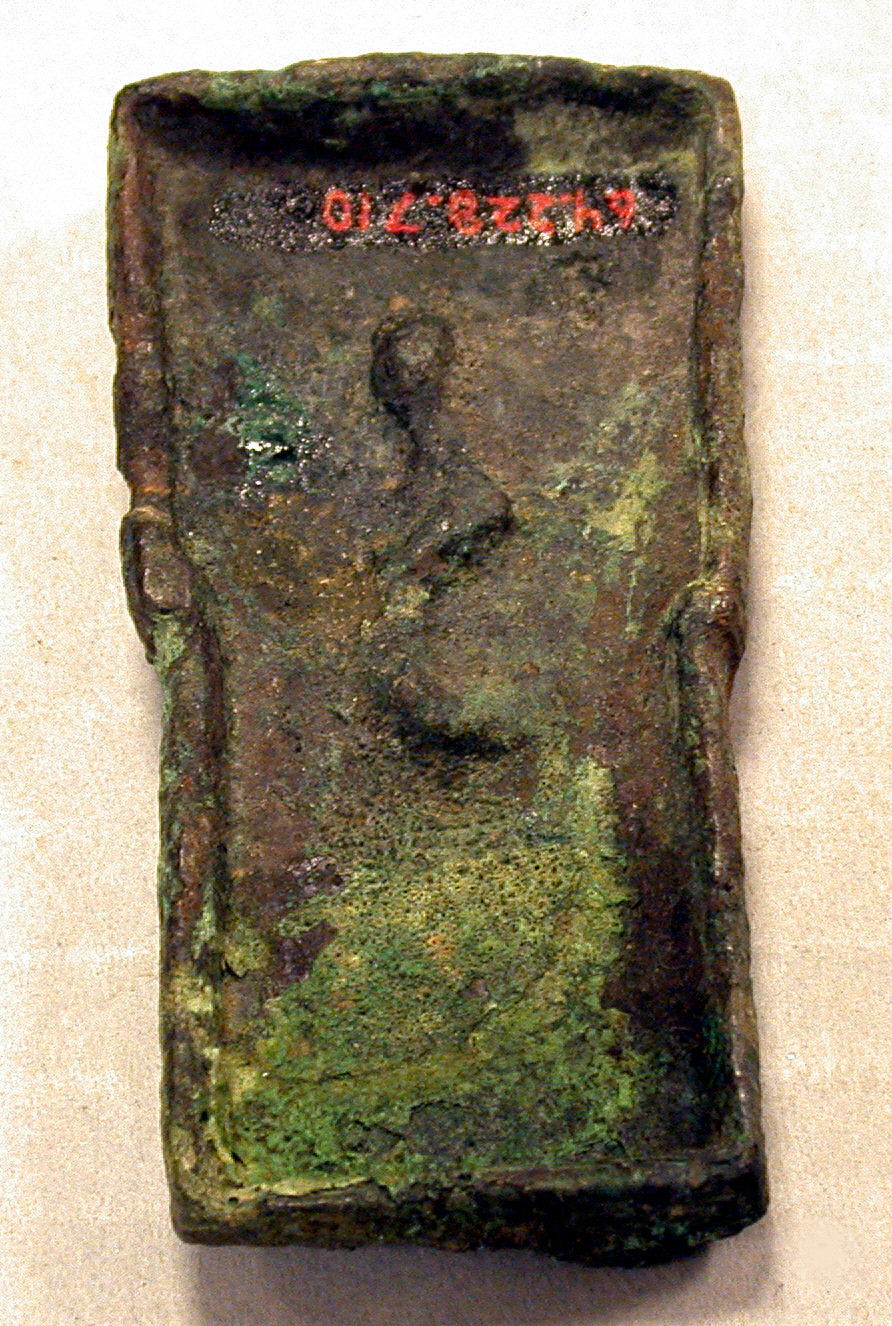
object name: tray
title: Cast Copper Tray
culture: peruvian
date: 1-1500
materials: copper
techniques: casting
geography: peru